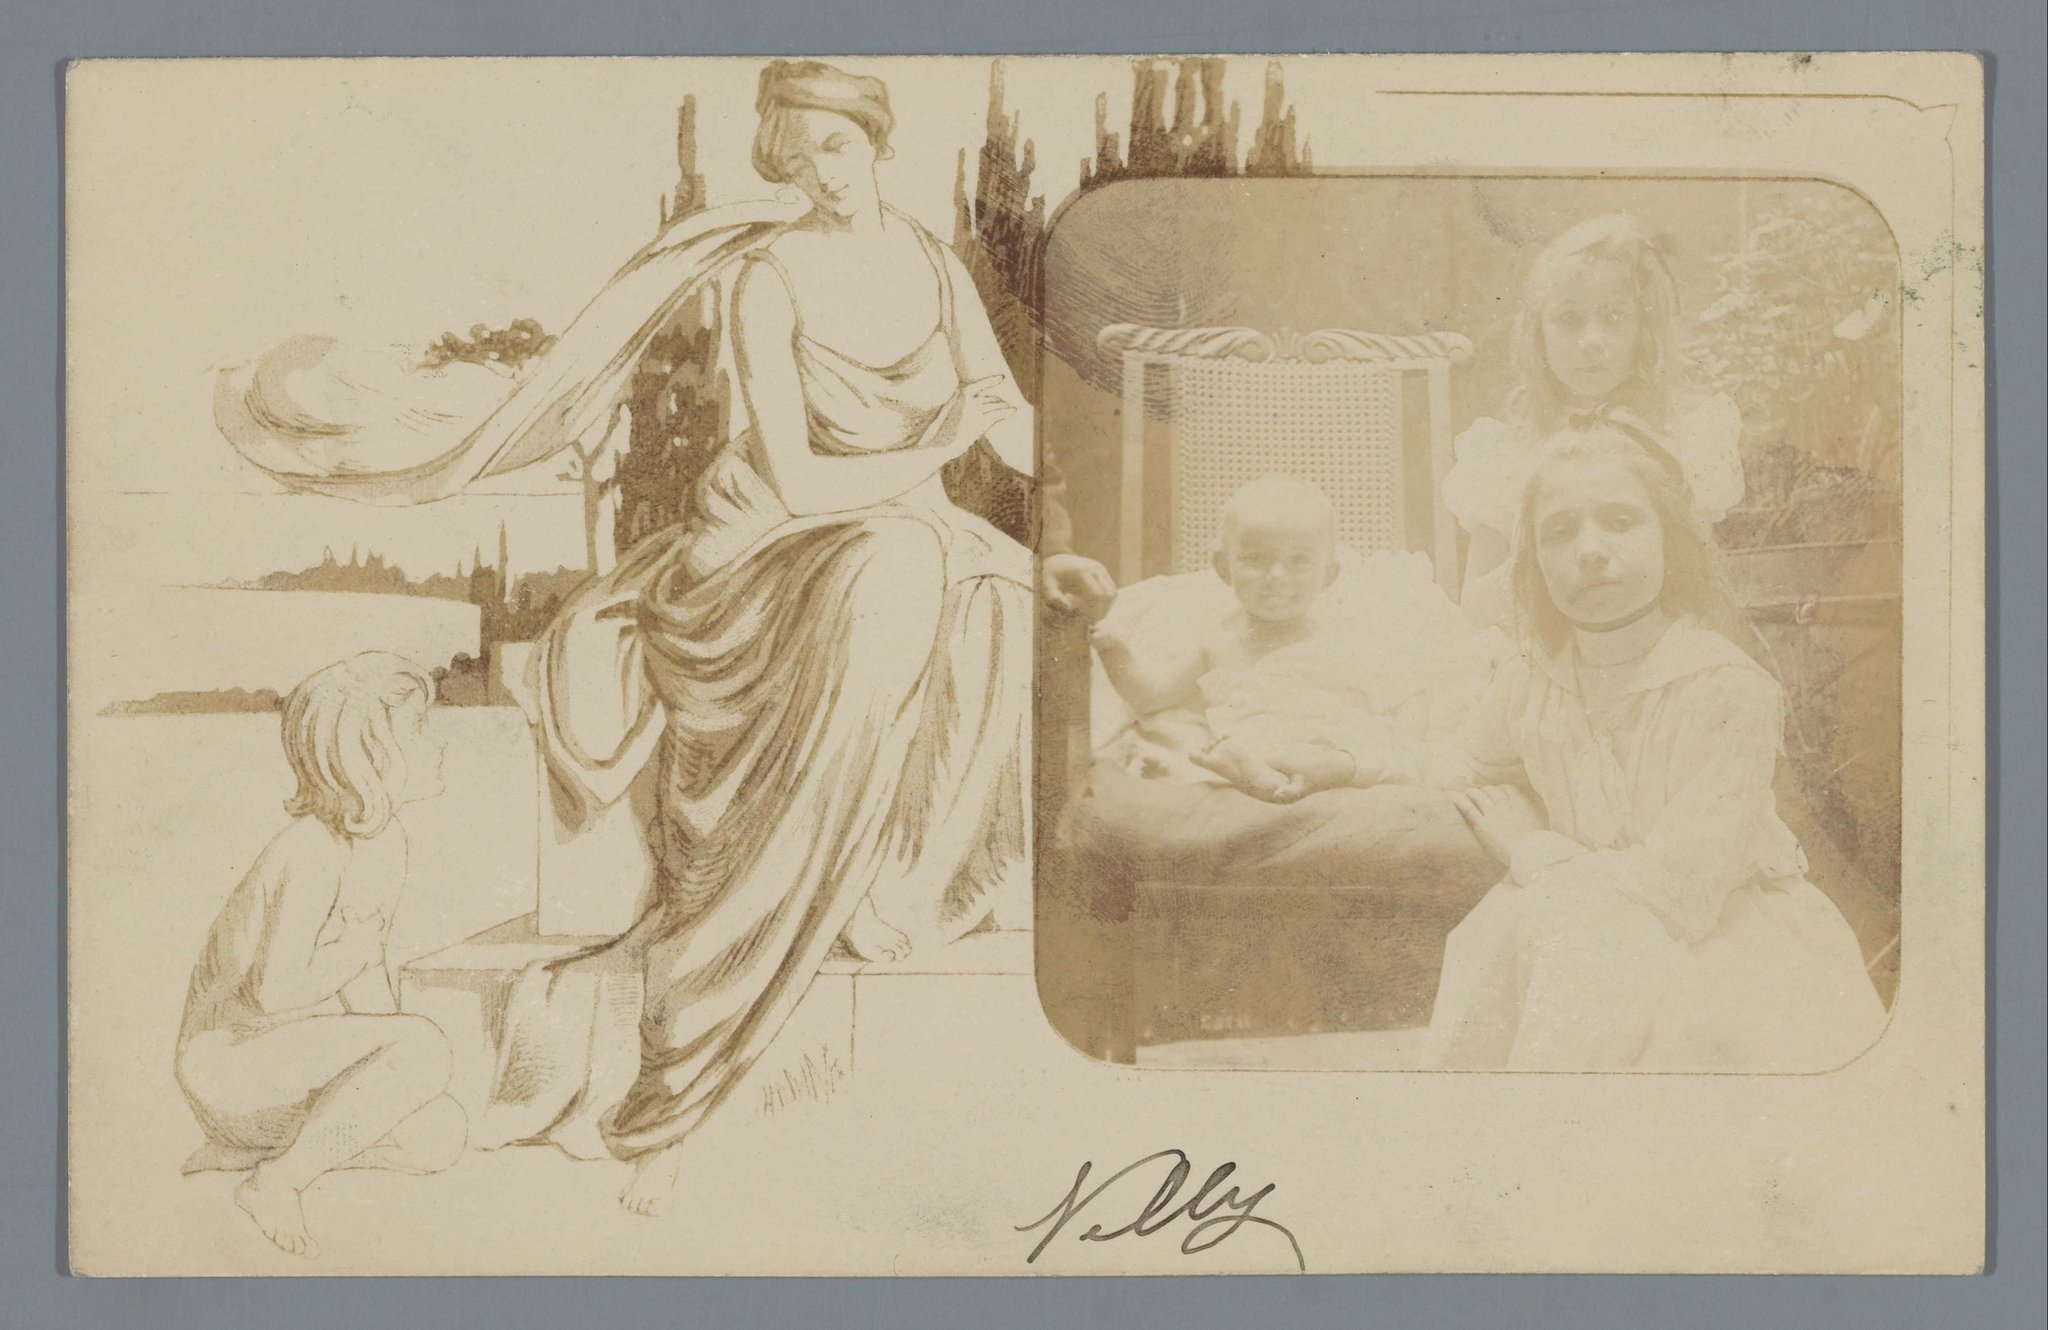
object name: photograph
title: Portret van drie onbekende kinderen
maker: Anonymous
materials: photographic support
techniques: gelatin silver print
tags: child (at home) - aa - girl, child (at home)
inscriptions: inscription: ‘Villy’, inscription: ‘Mademoiselle G. Delcorde (...) Molenbeek ouest’